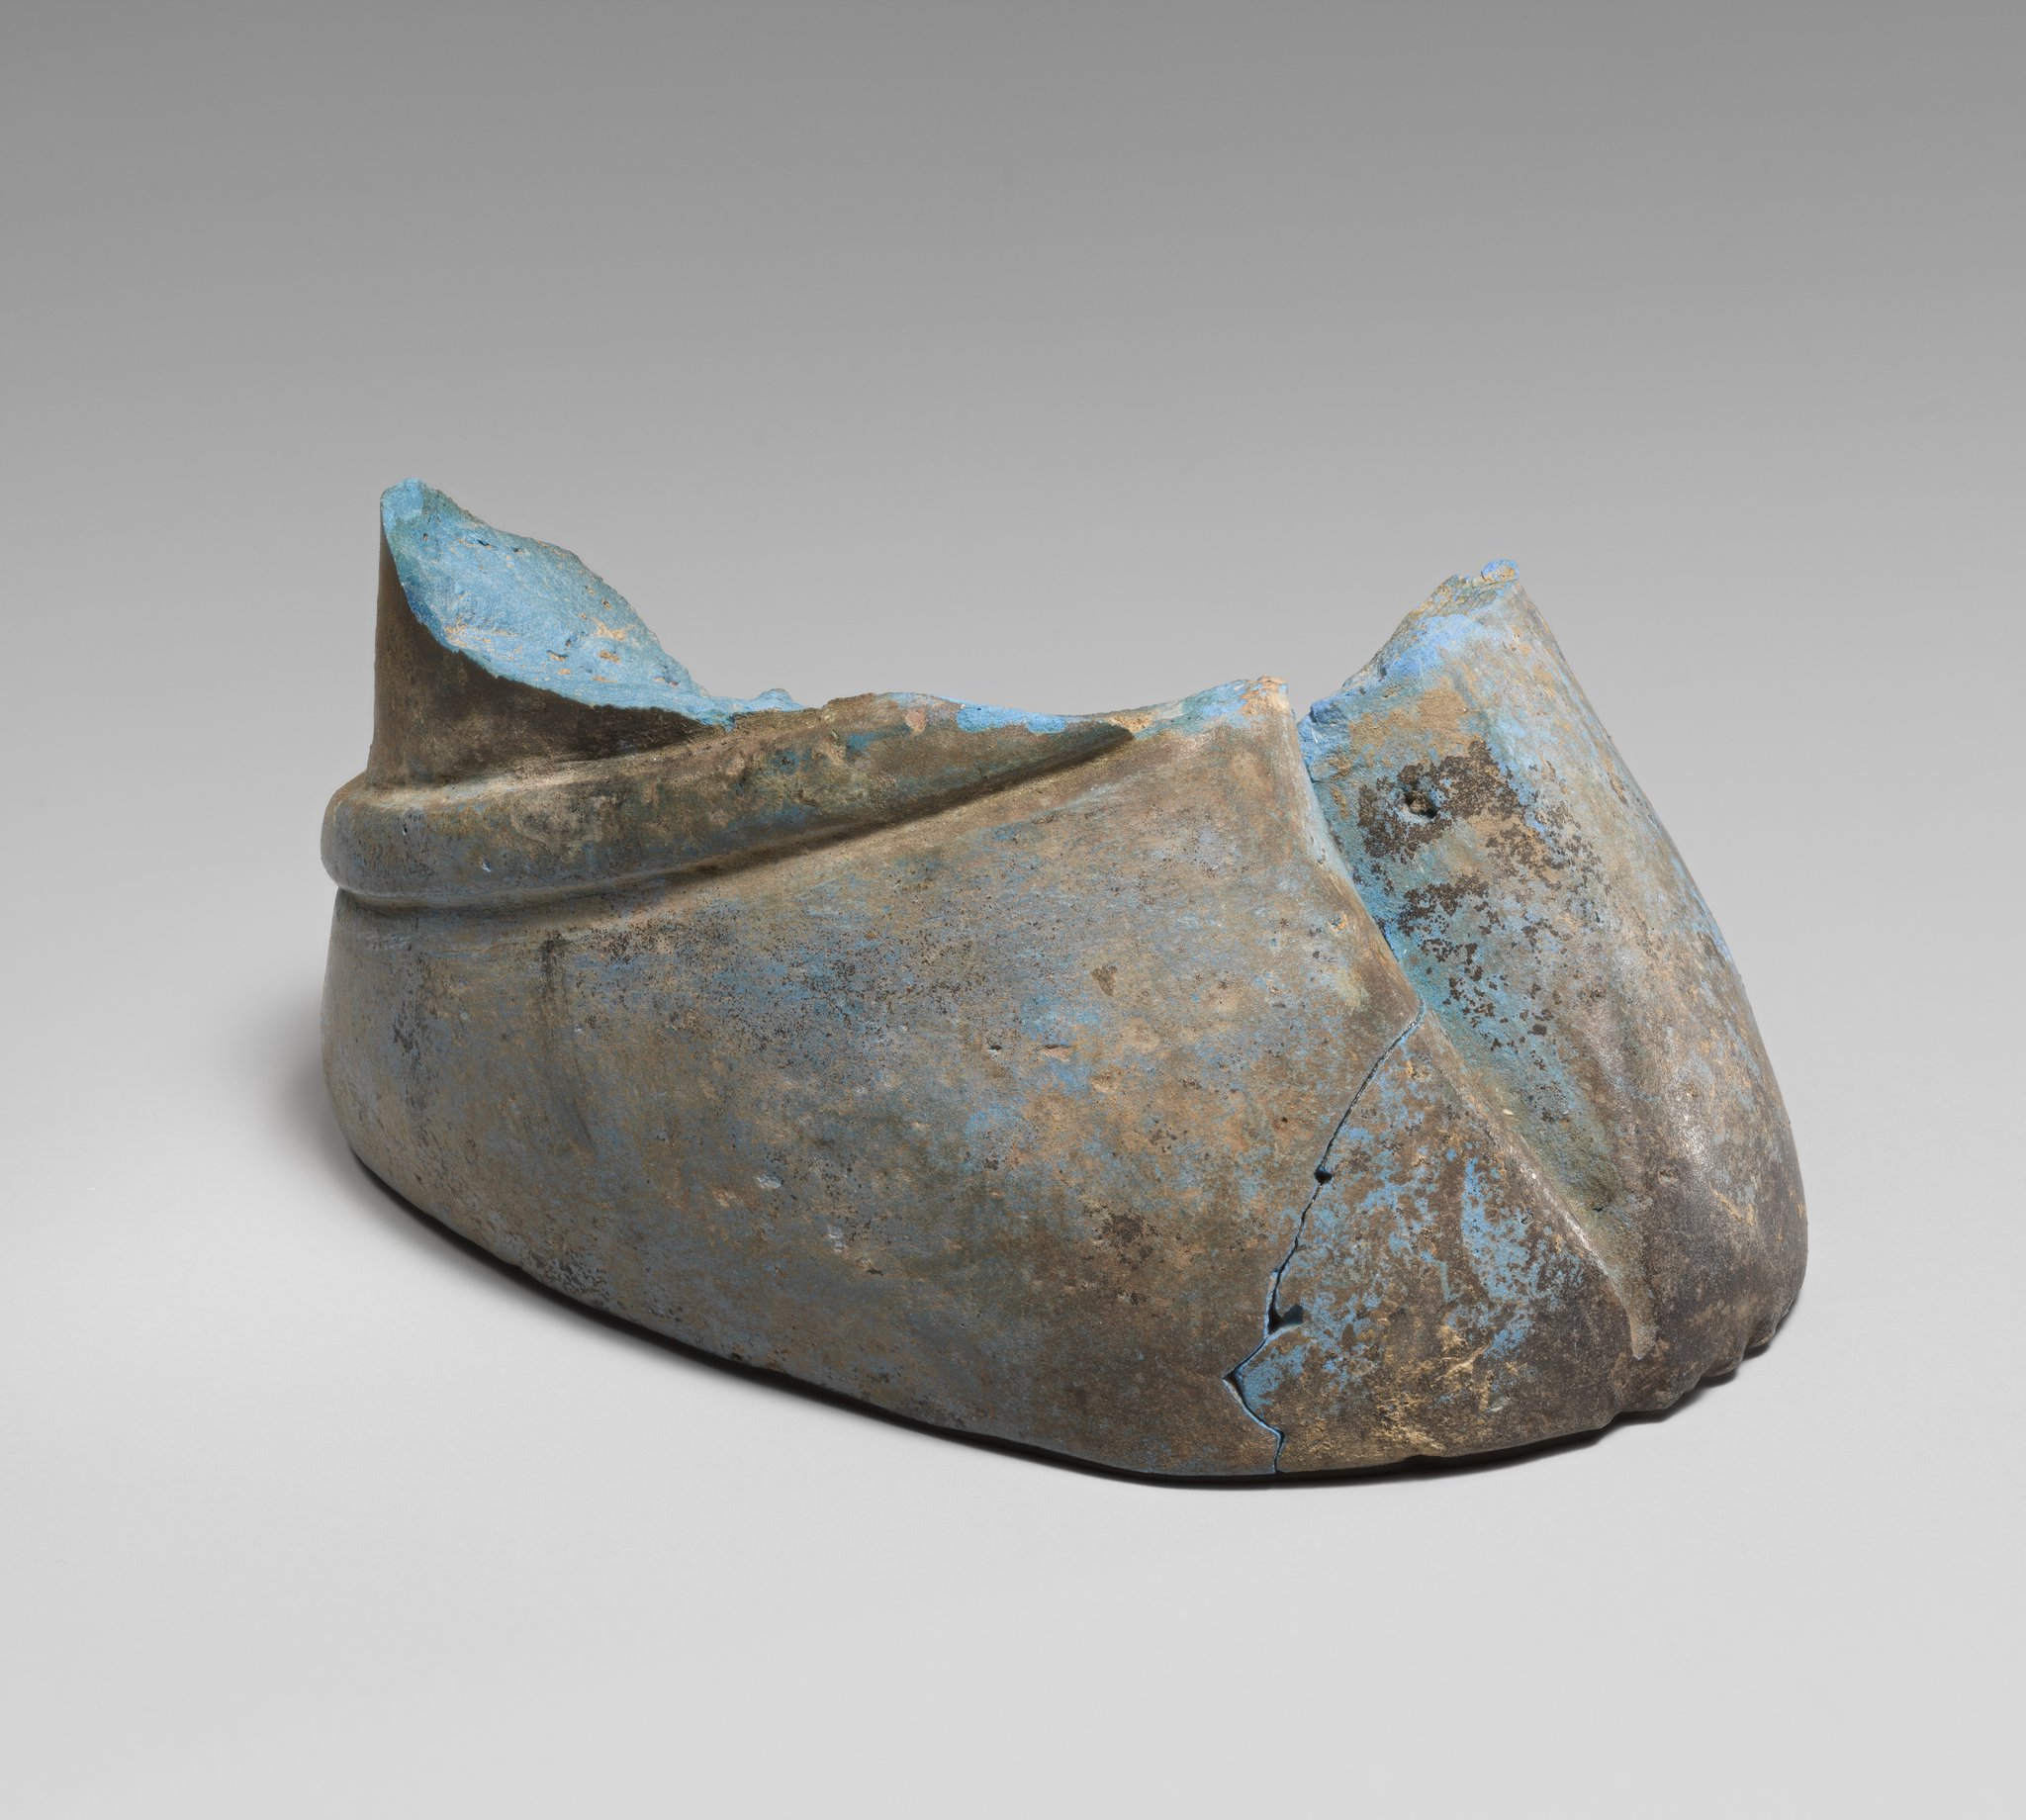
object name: furniture element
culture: iranian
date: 900-801 BCE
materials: glass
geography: iran